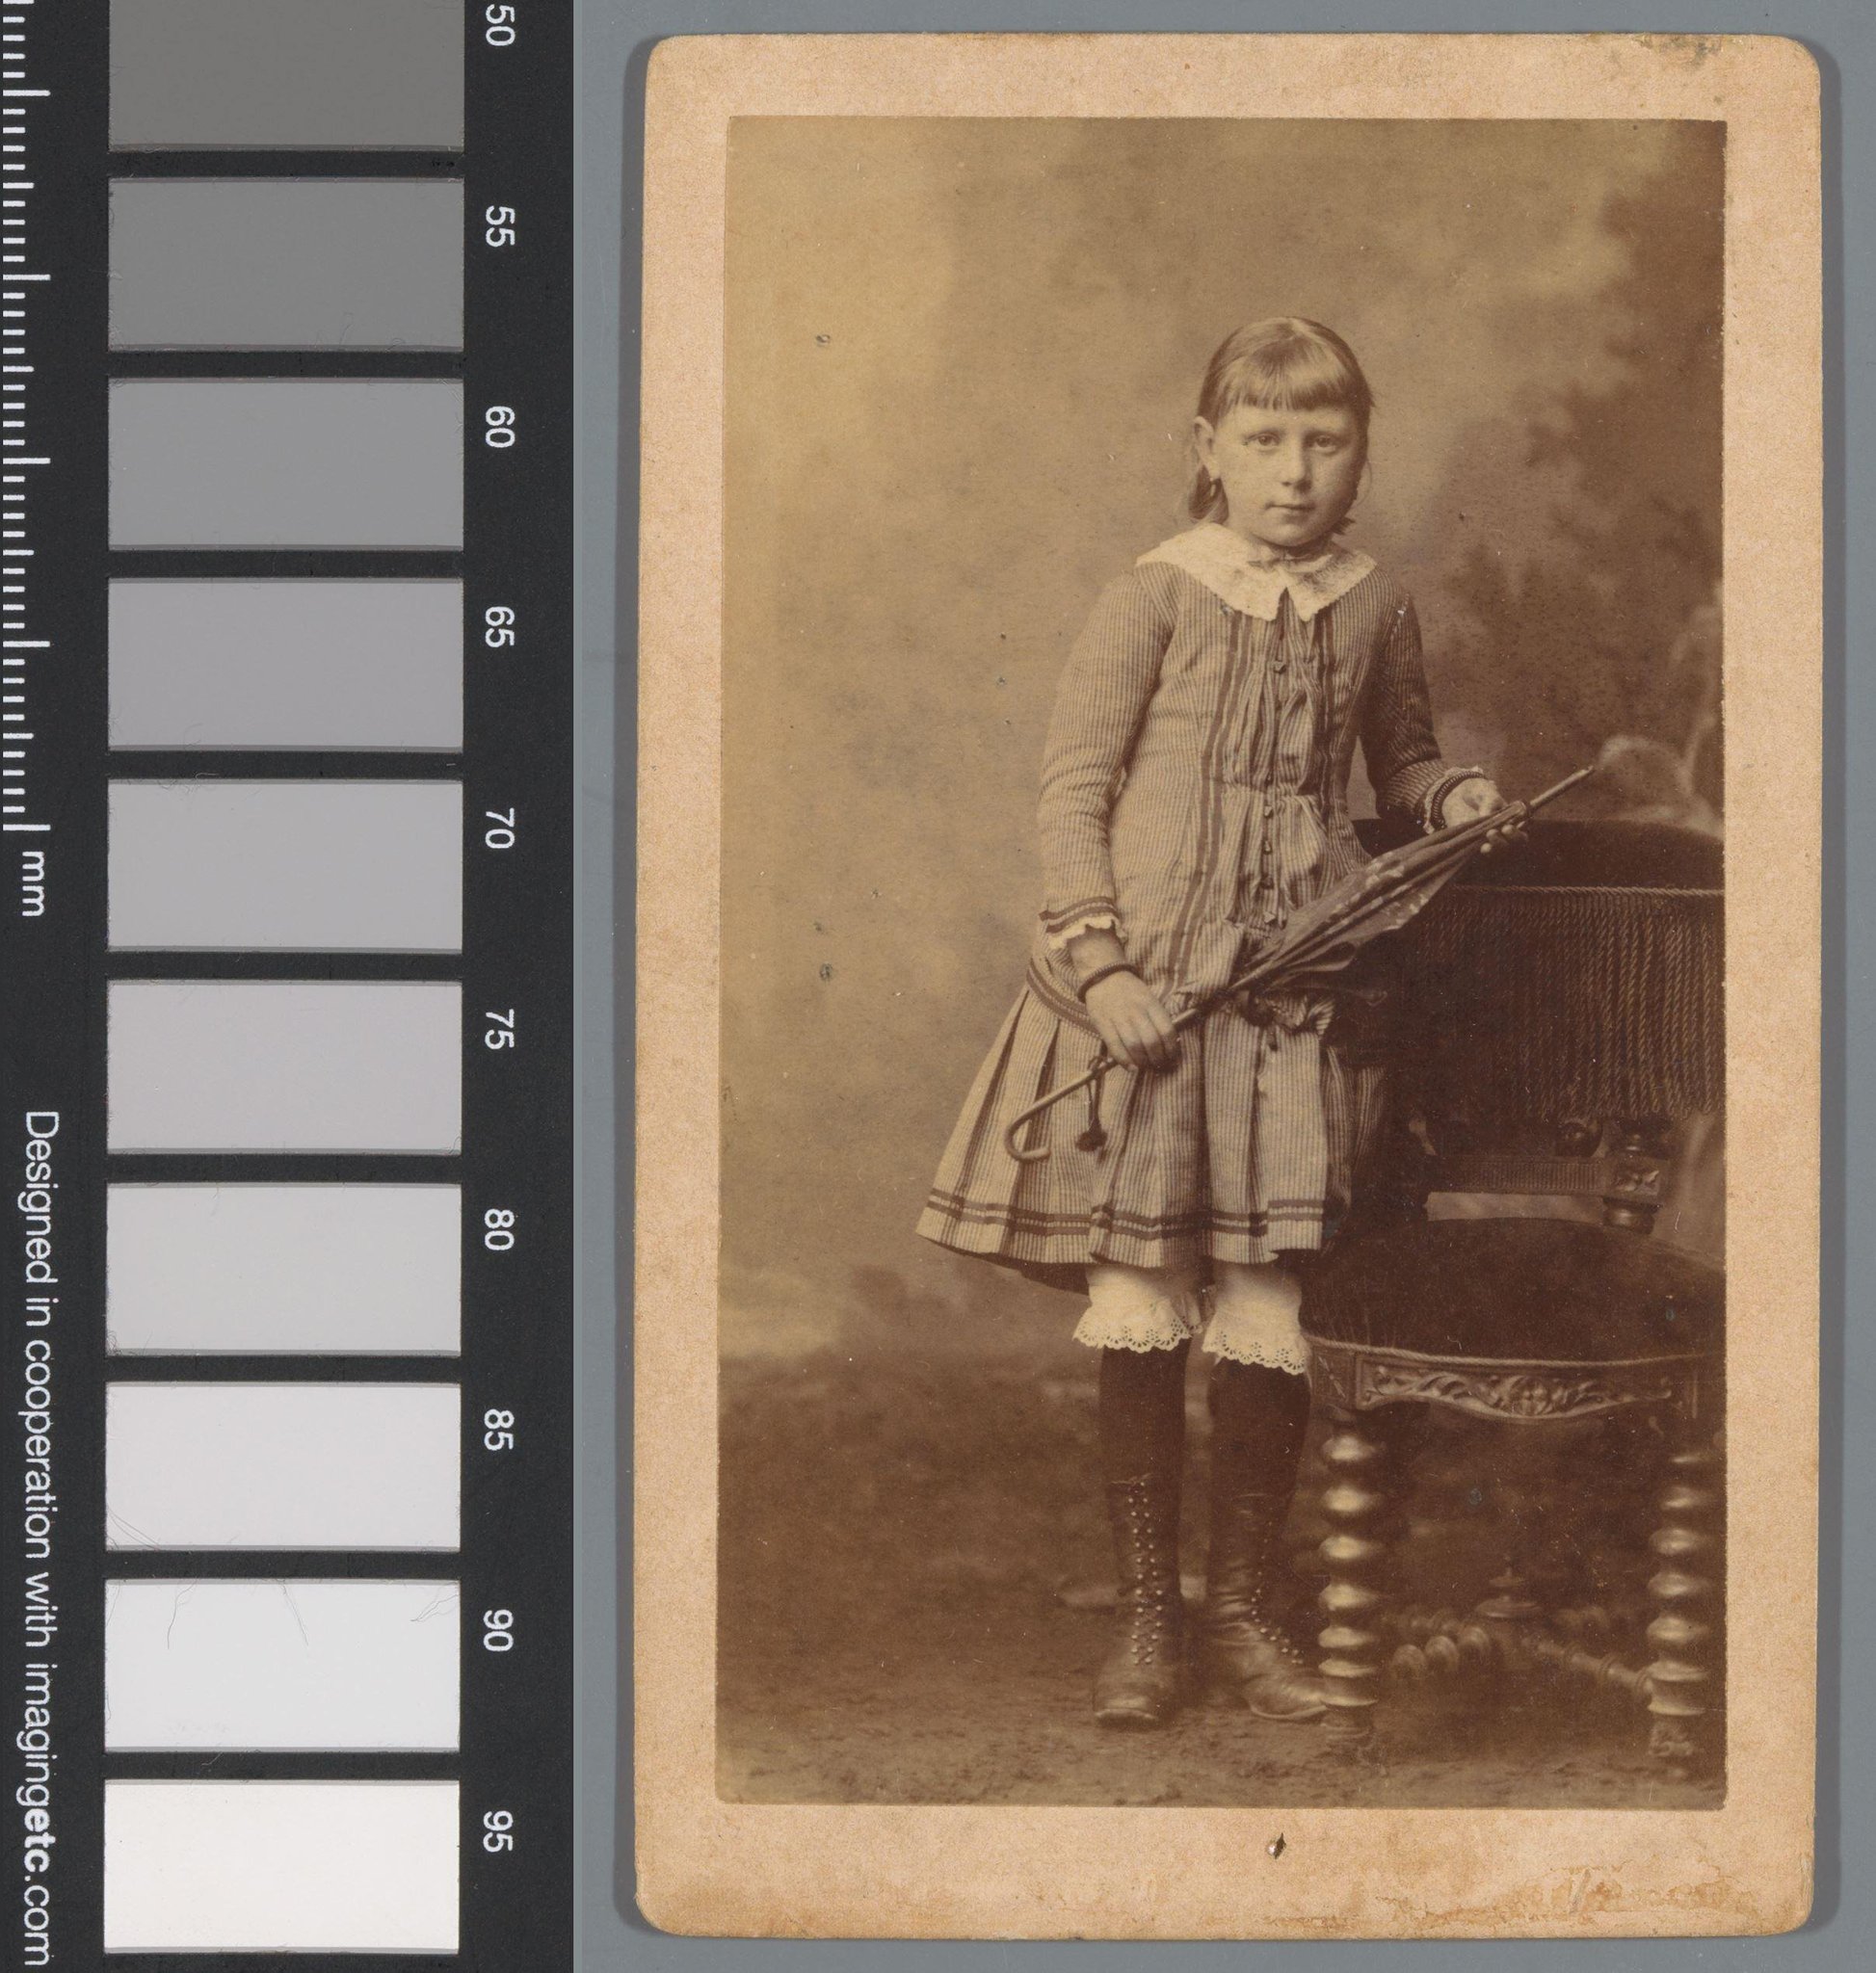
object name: photograph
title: Portret van een onbekend meisje, leunend tegen een stoel met een paraplu in de hand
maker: b.j. pottjewijd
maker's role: fotograaf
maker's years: 1859-1941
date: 1880-1900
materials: cardboard, paper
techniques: albumen print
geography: winschoten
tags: historical persons, girl (child between toddler and youth), umbrella, chair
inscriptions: inscription: ‘PHOTOGRAPHIE/ B. J. Pottjewijd/ WINSCHOTEN/ Het negatief blijft voor nabestelling bewaard/ Vergrootingen in alle afmetingen.’